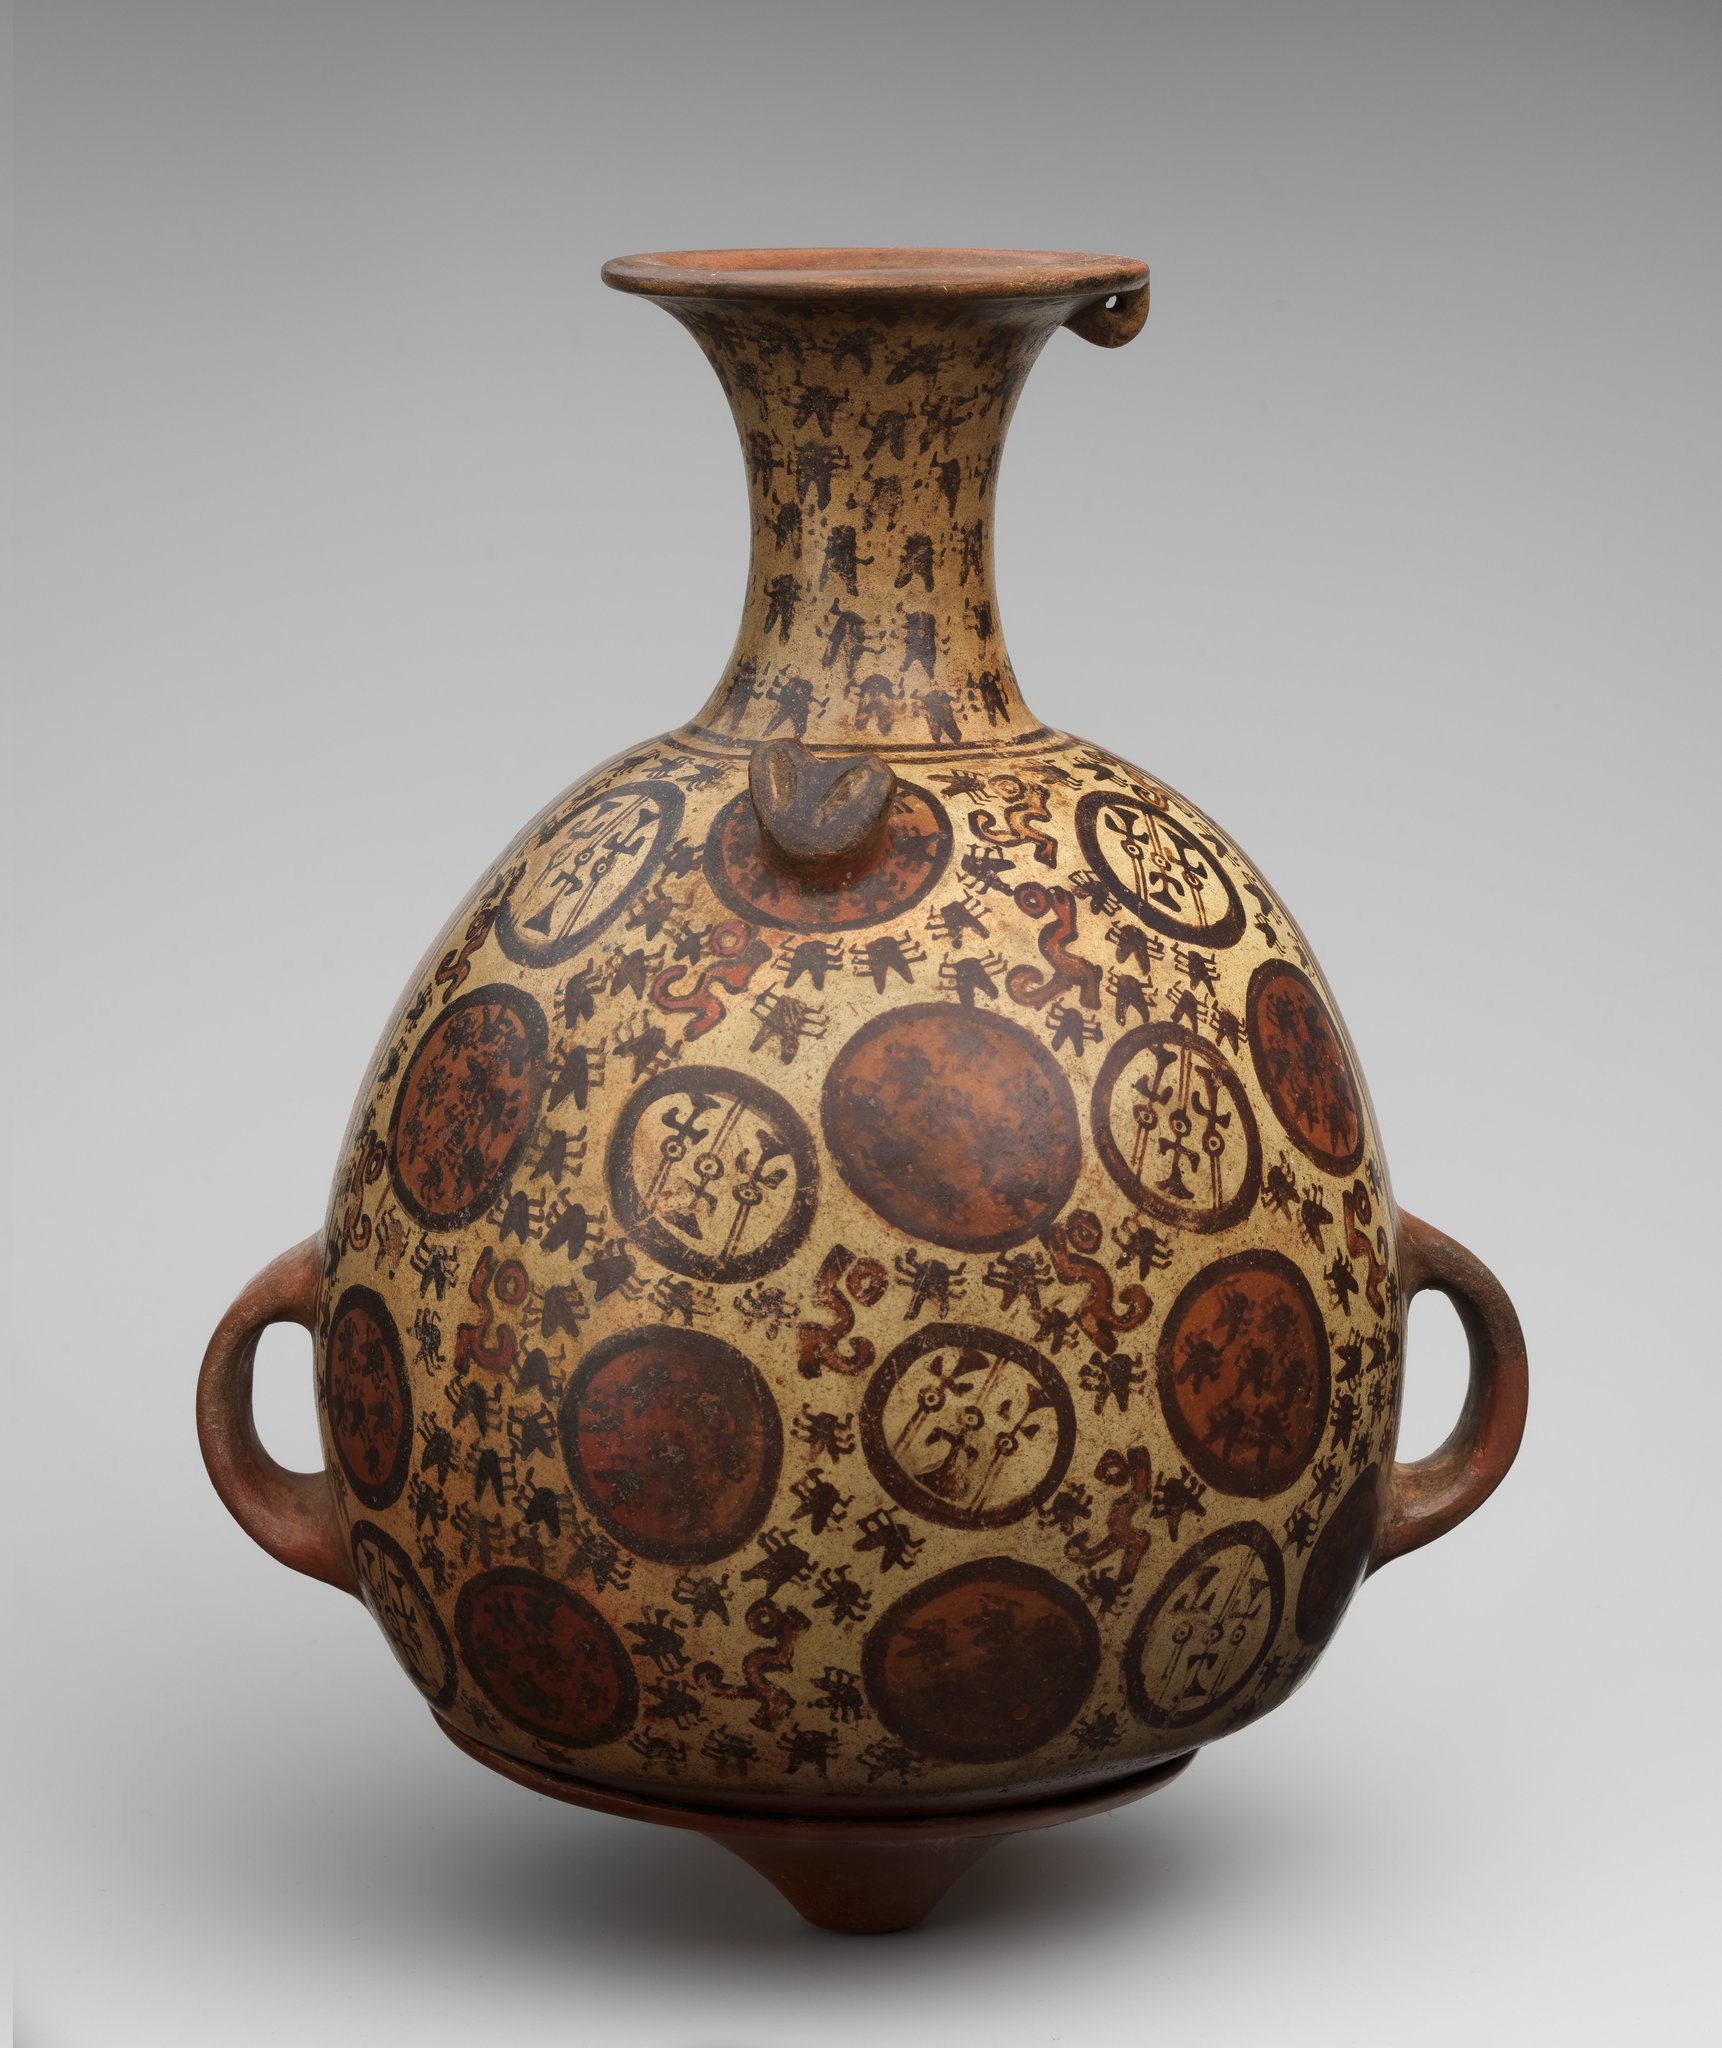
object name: bottle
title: Urpu (jar)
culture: inca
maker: inca artist(s)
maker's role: artist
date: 1400-1535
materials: ceramic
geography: peru